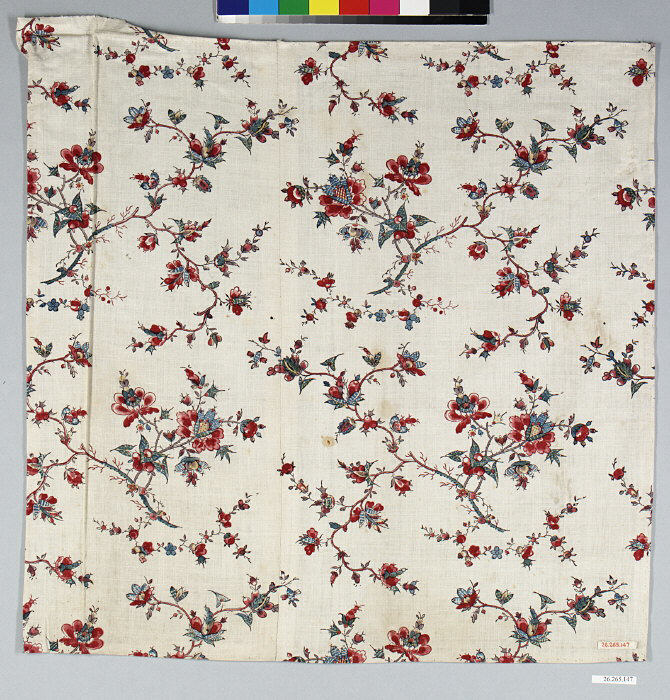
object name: piece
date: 1767-1800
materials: cotton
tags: flowers,leaves